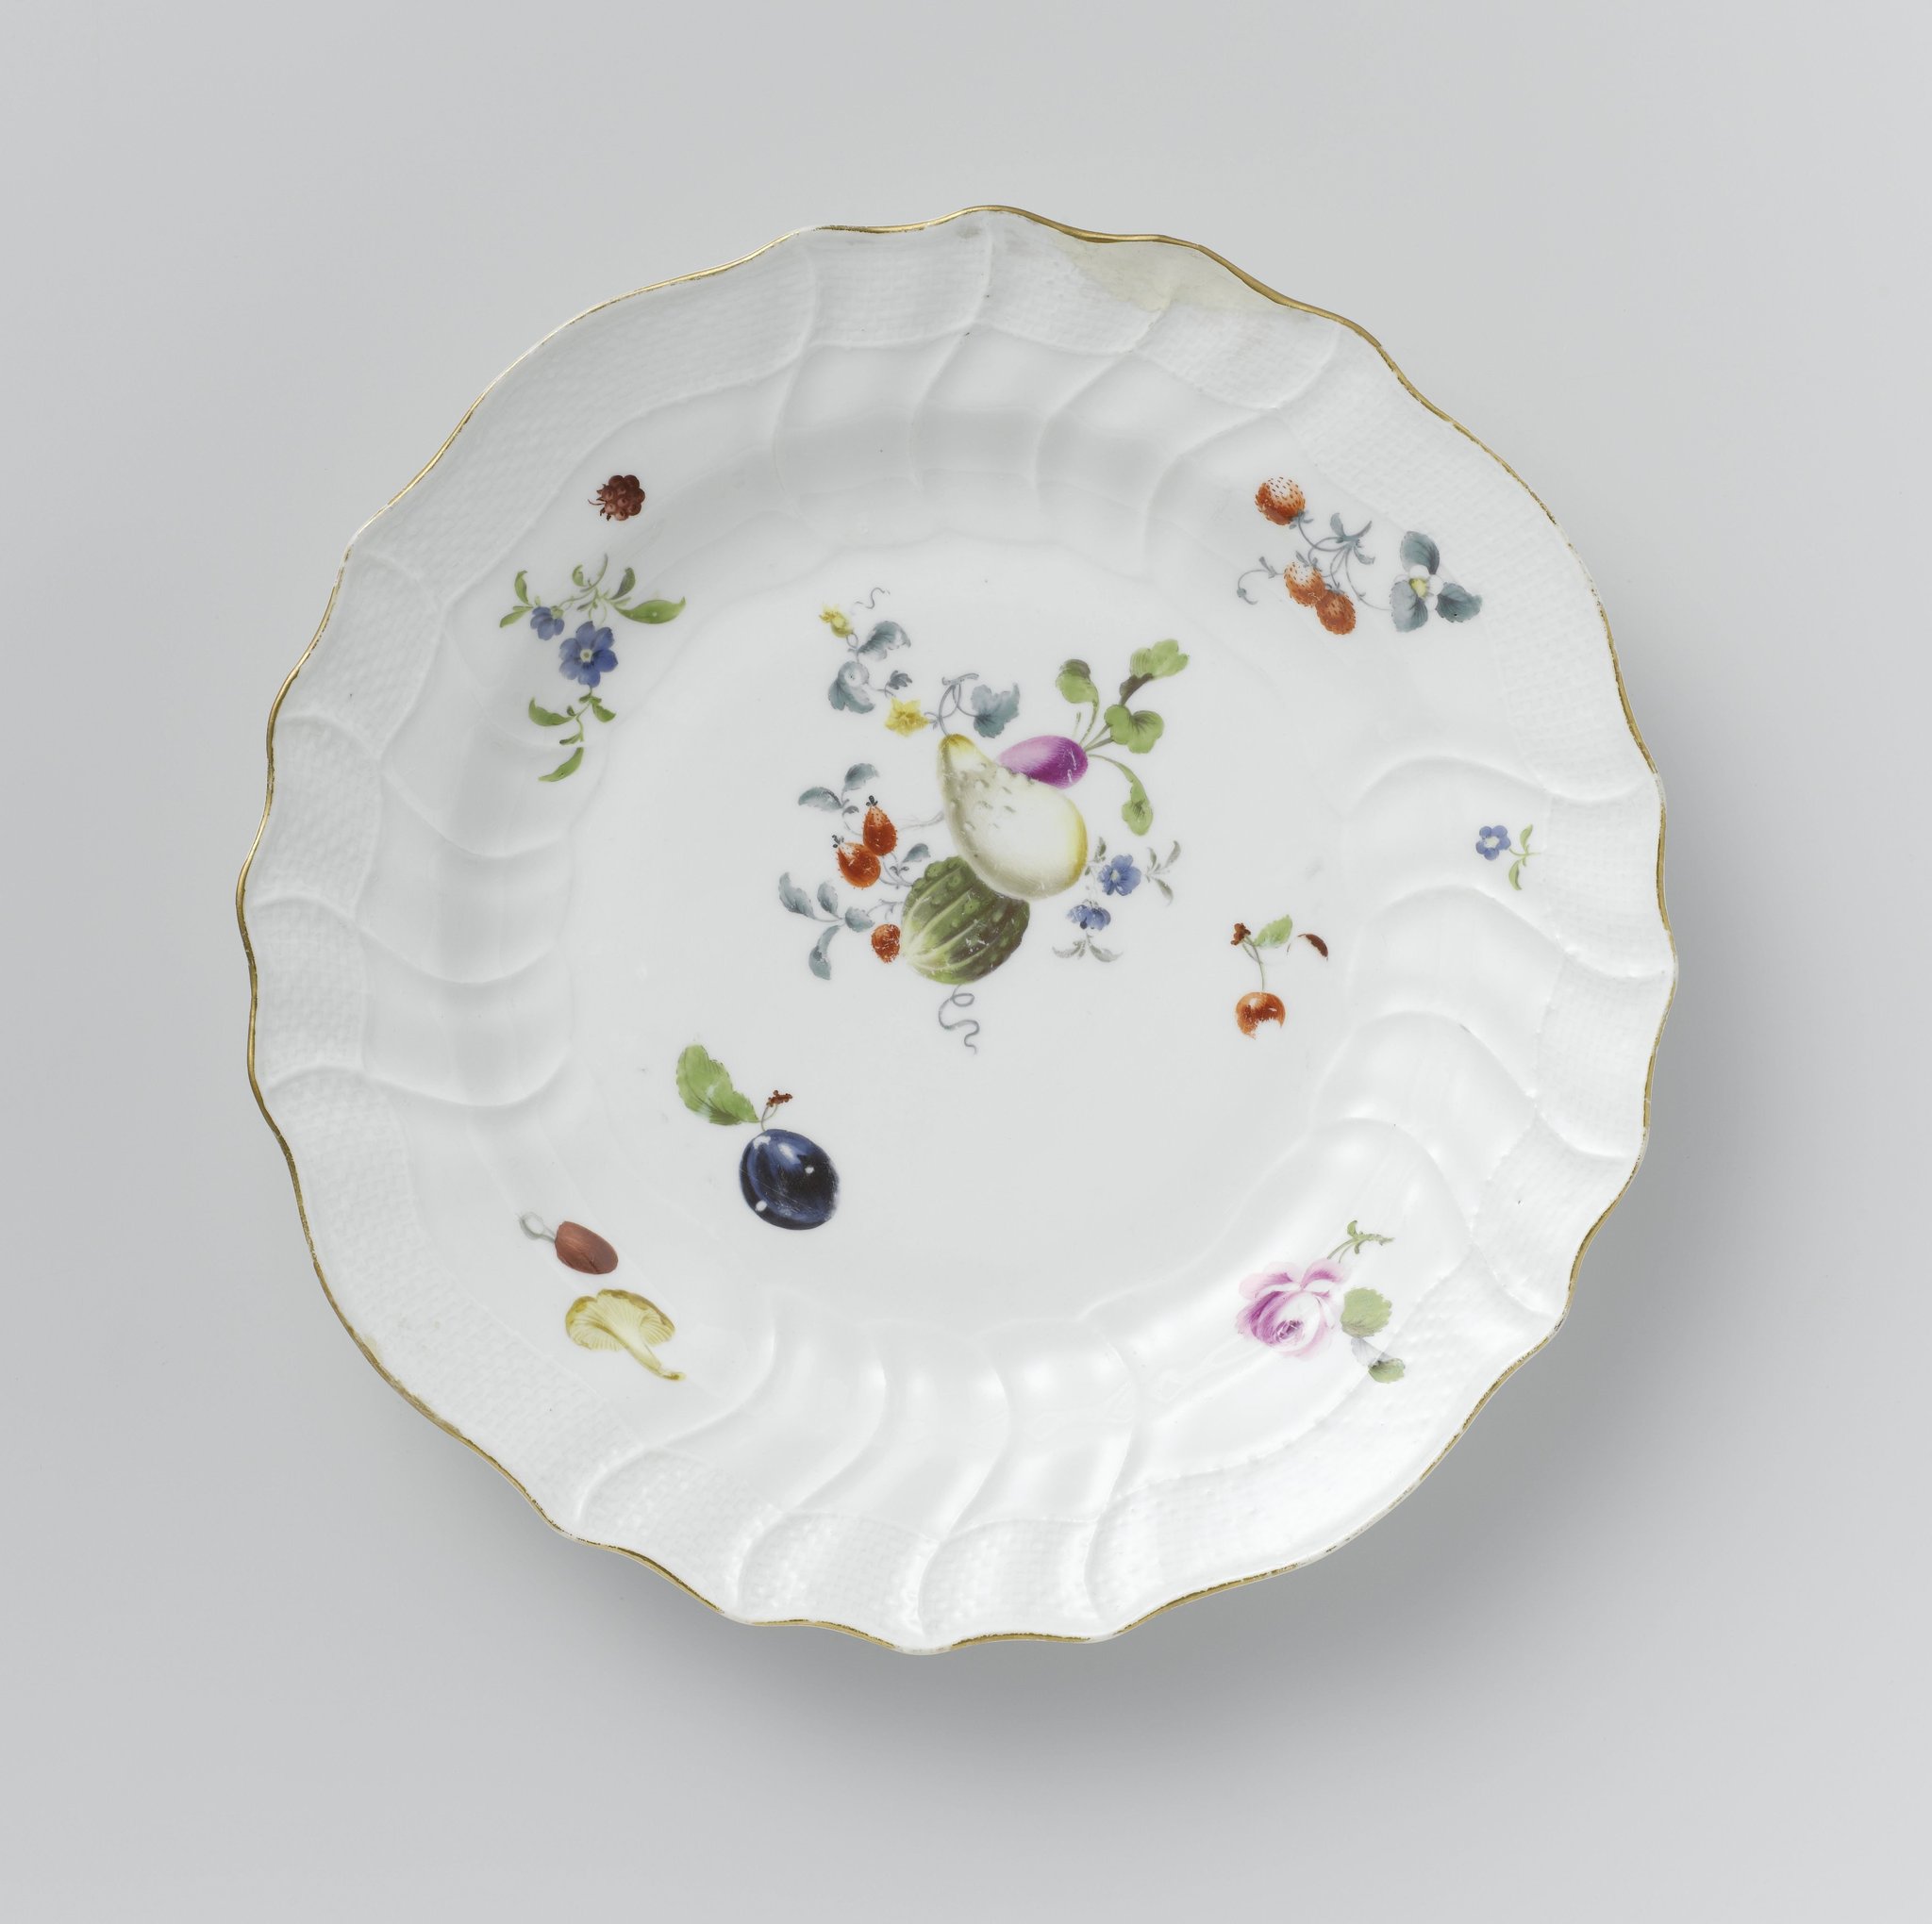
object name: plate dish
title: Bord, veelkleurig beschilderd met Deutsche Blumen, insekten en vruchten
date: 1750-1760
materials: porcelain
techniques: painted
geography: meissen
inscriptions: factory mark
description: Rond bord van beschilderd porselein. Het bord is beschilderd met Deutsche Blumen, insekten en vruchten. De rand is in reliëf versierd met het Neuozier-patroon. Het bord is gemerkt en hoort bij een servies (BK-17474-1 t/m BK-17474-253).